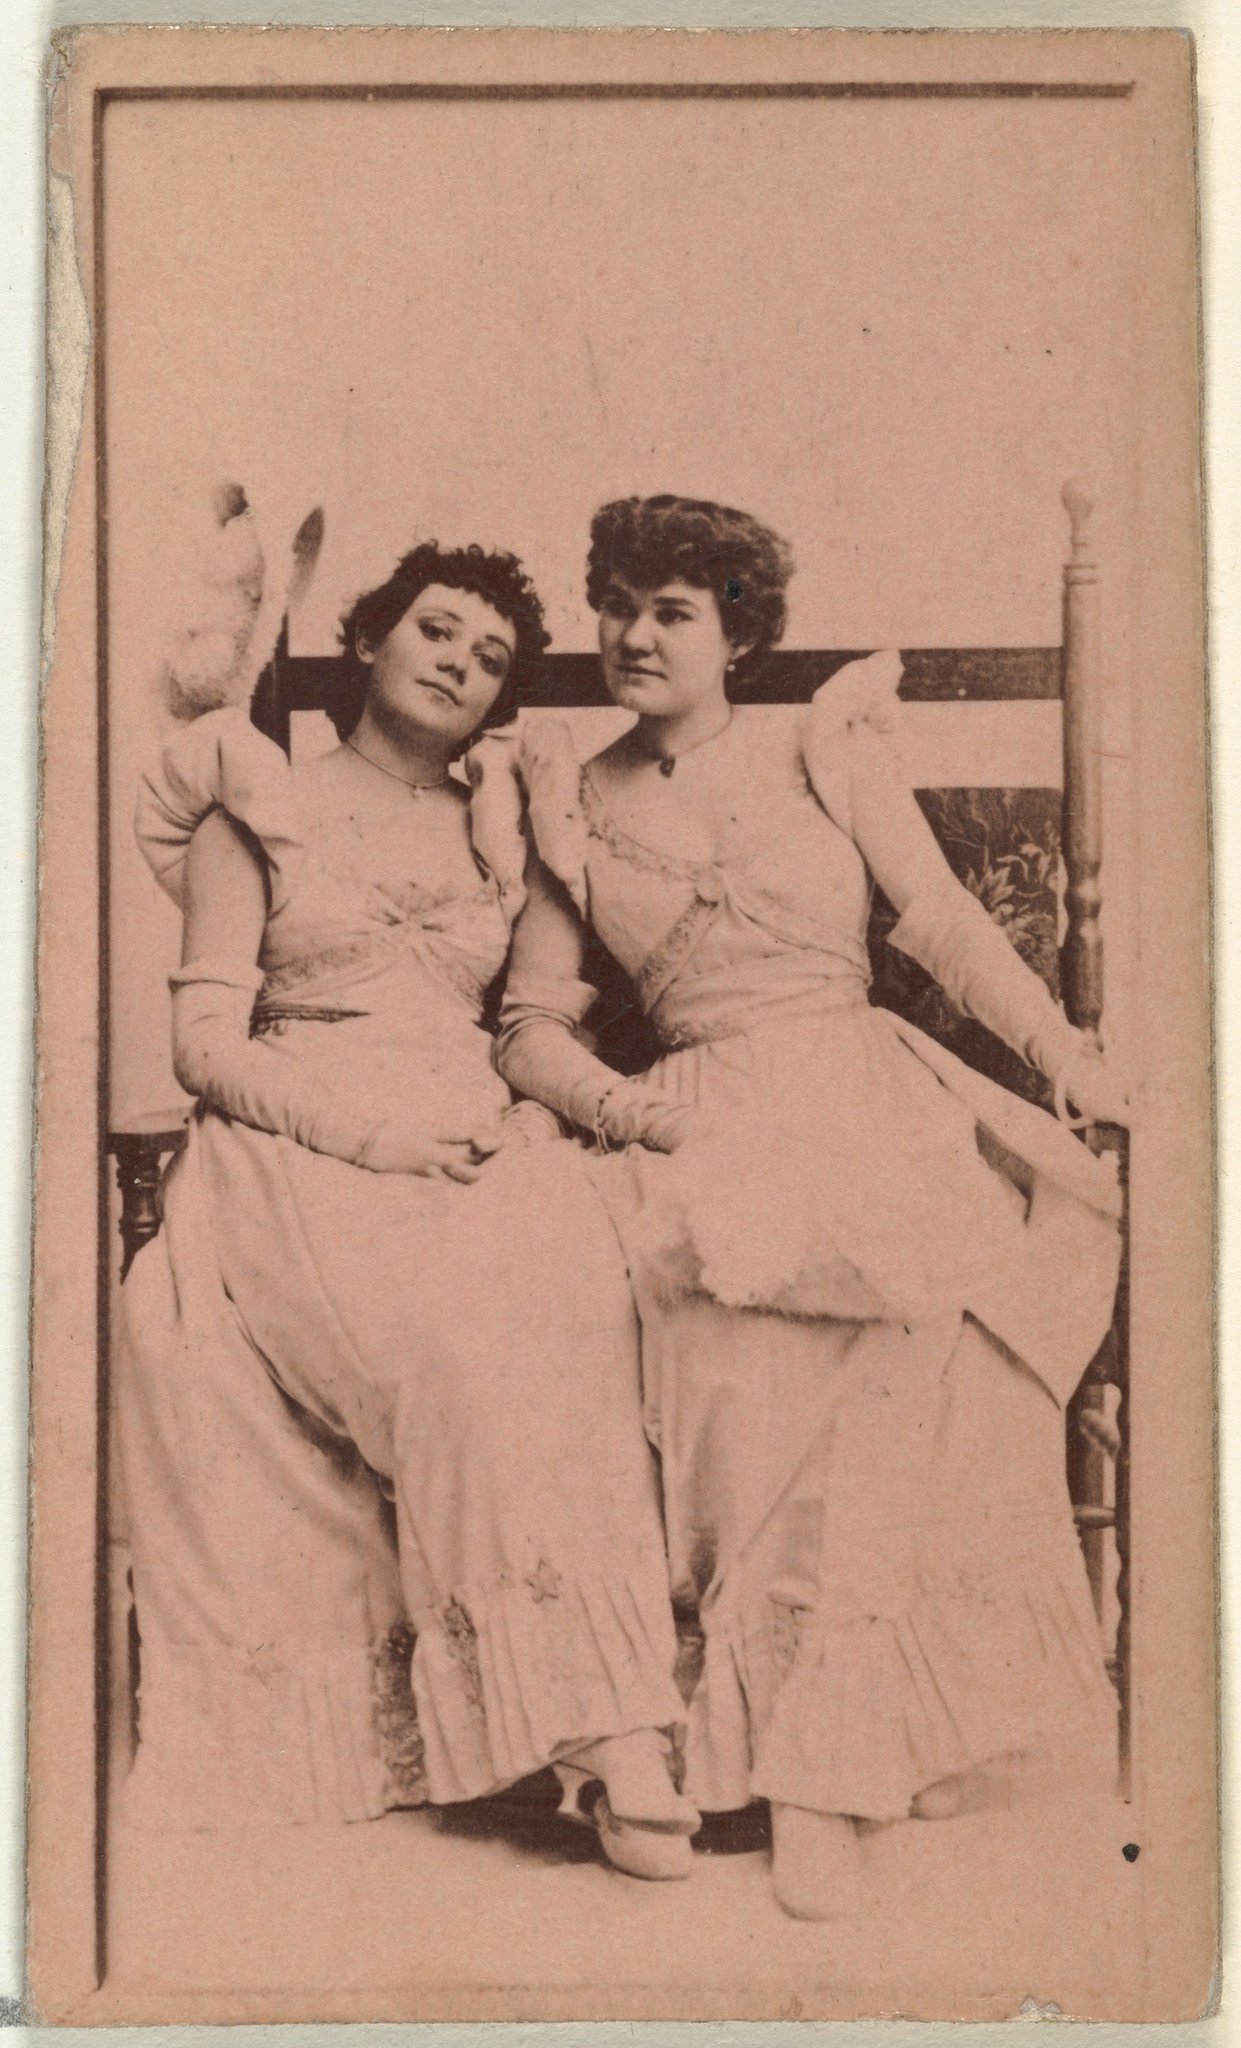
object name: photograph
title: [Two seated actresses], from the Actors and Actresses series (N145-8) issued by Duke Sons & Co. to promote Duke Cigarettes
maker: w. duke, sons & co.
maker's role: publisher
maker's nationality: american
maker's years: 1870-1920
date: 1891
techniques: albumen silver print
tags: portraits,women,actresses